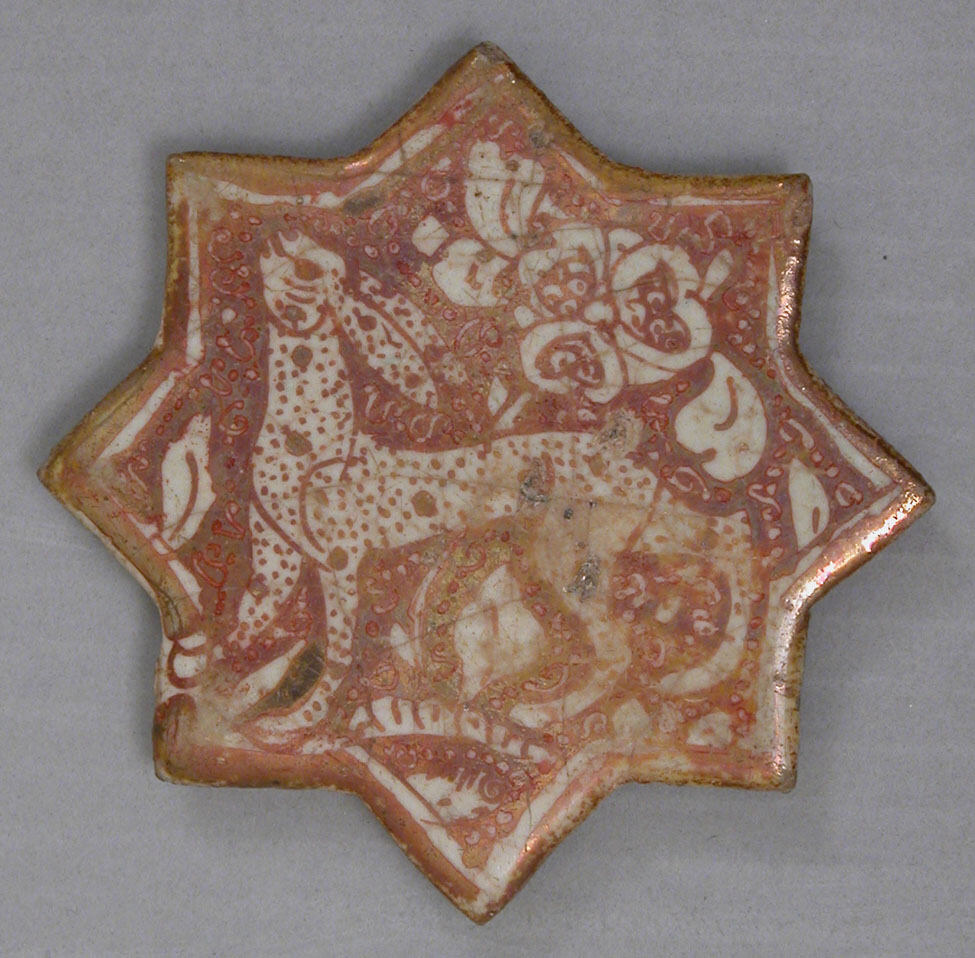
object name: tile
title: Star-Shaped Tile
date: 1167-1233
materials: glaze, stonepaste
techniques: luster painting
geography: iran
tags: animals